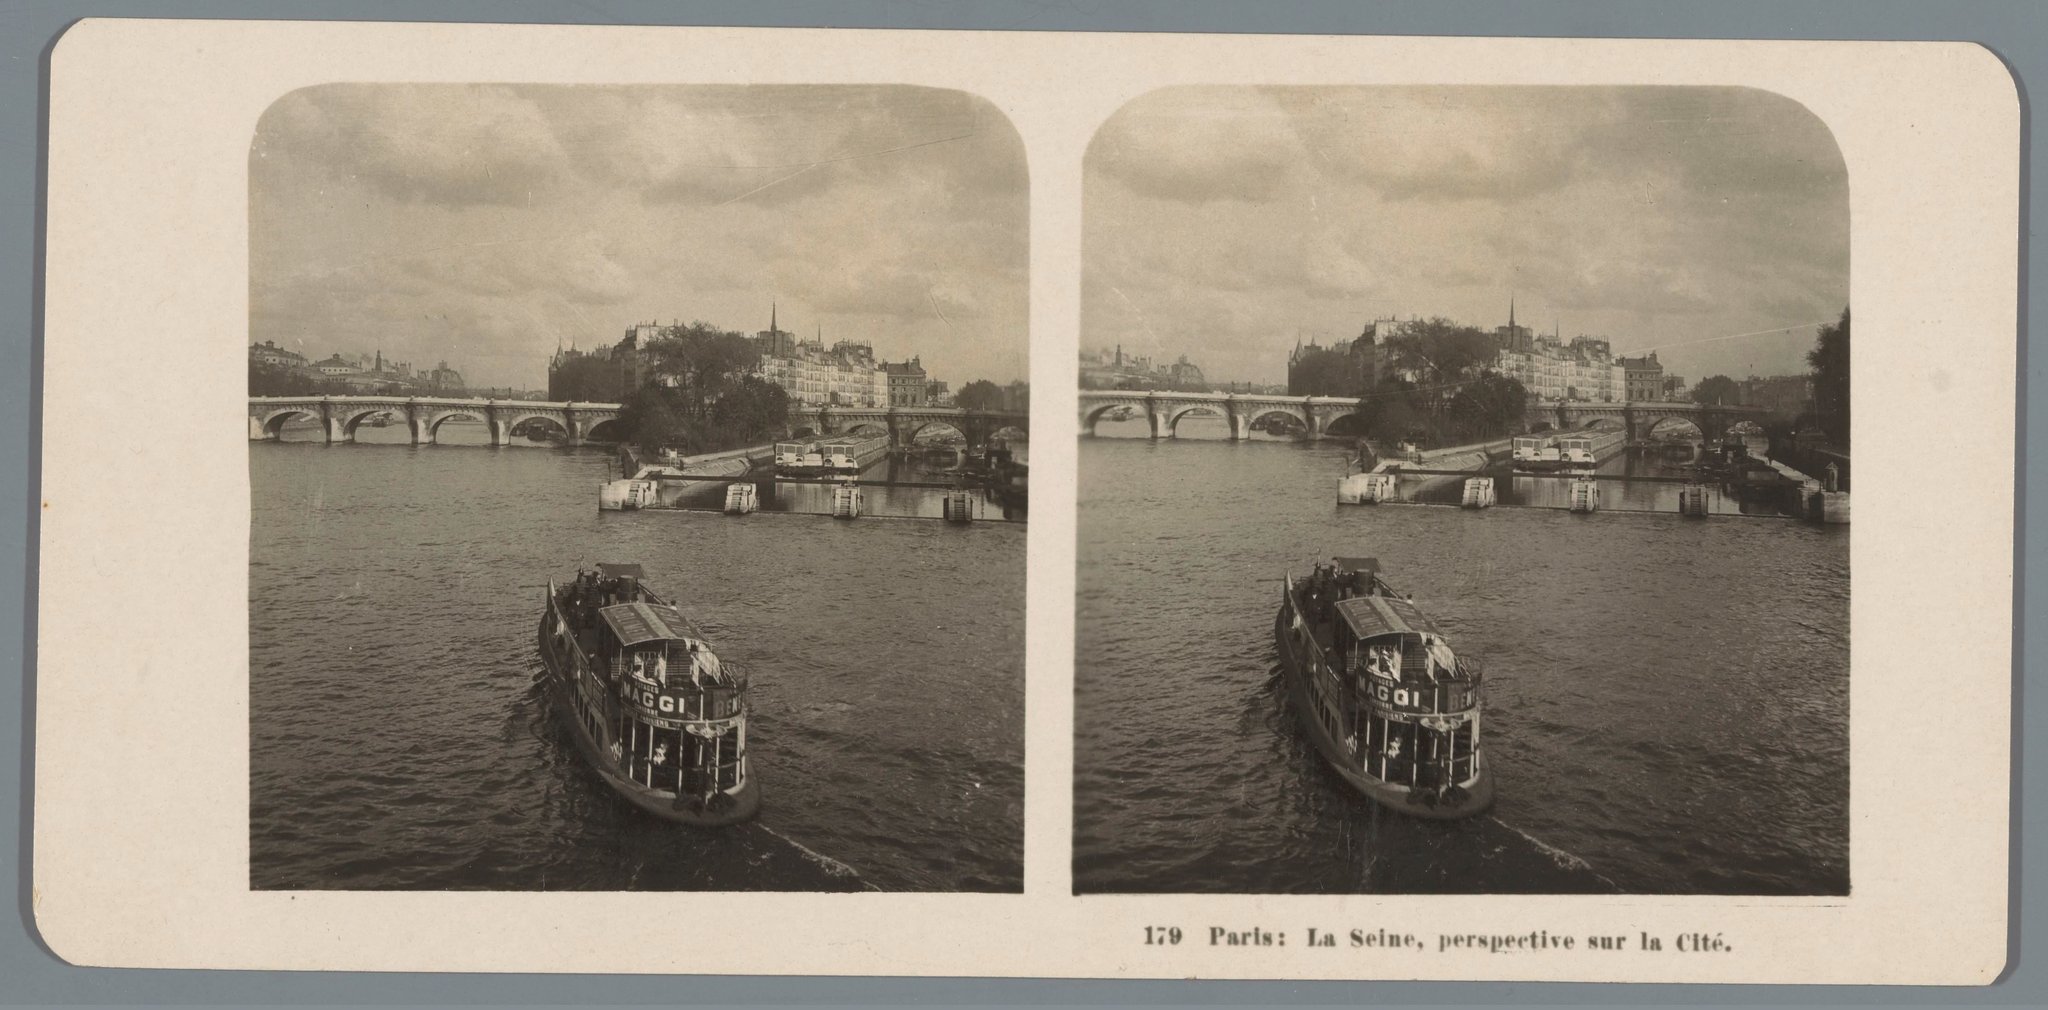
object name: stereograph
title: Gezicht op de Seine te Parijs, met op de achtergrond het Île de la Cité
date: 1895-1905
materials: cardboard, photographic support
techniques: gelatin silver print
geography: paris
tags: river, traffic on the water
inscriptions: number: ‘179’, inscription: ‘NPG’